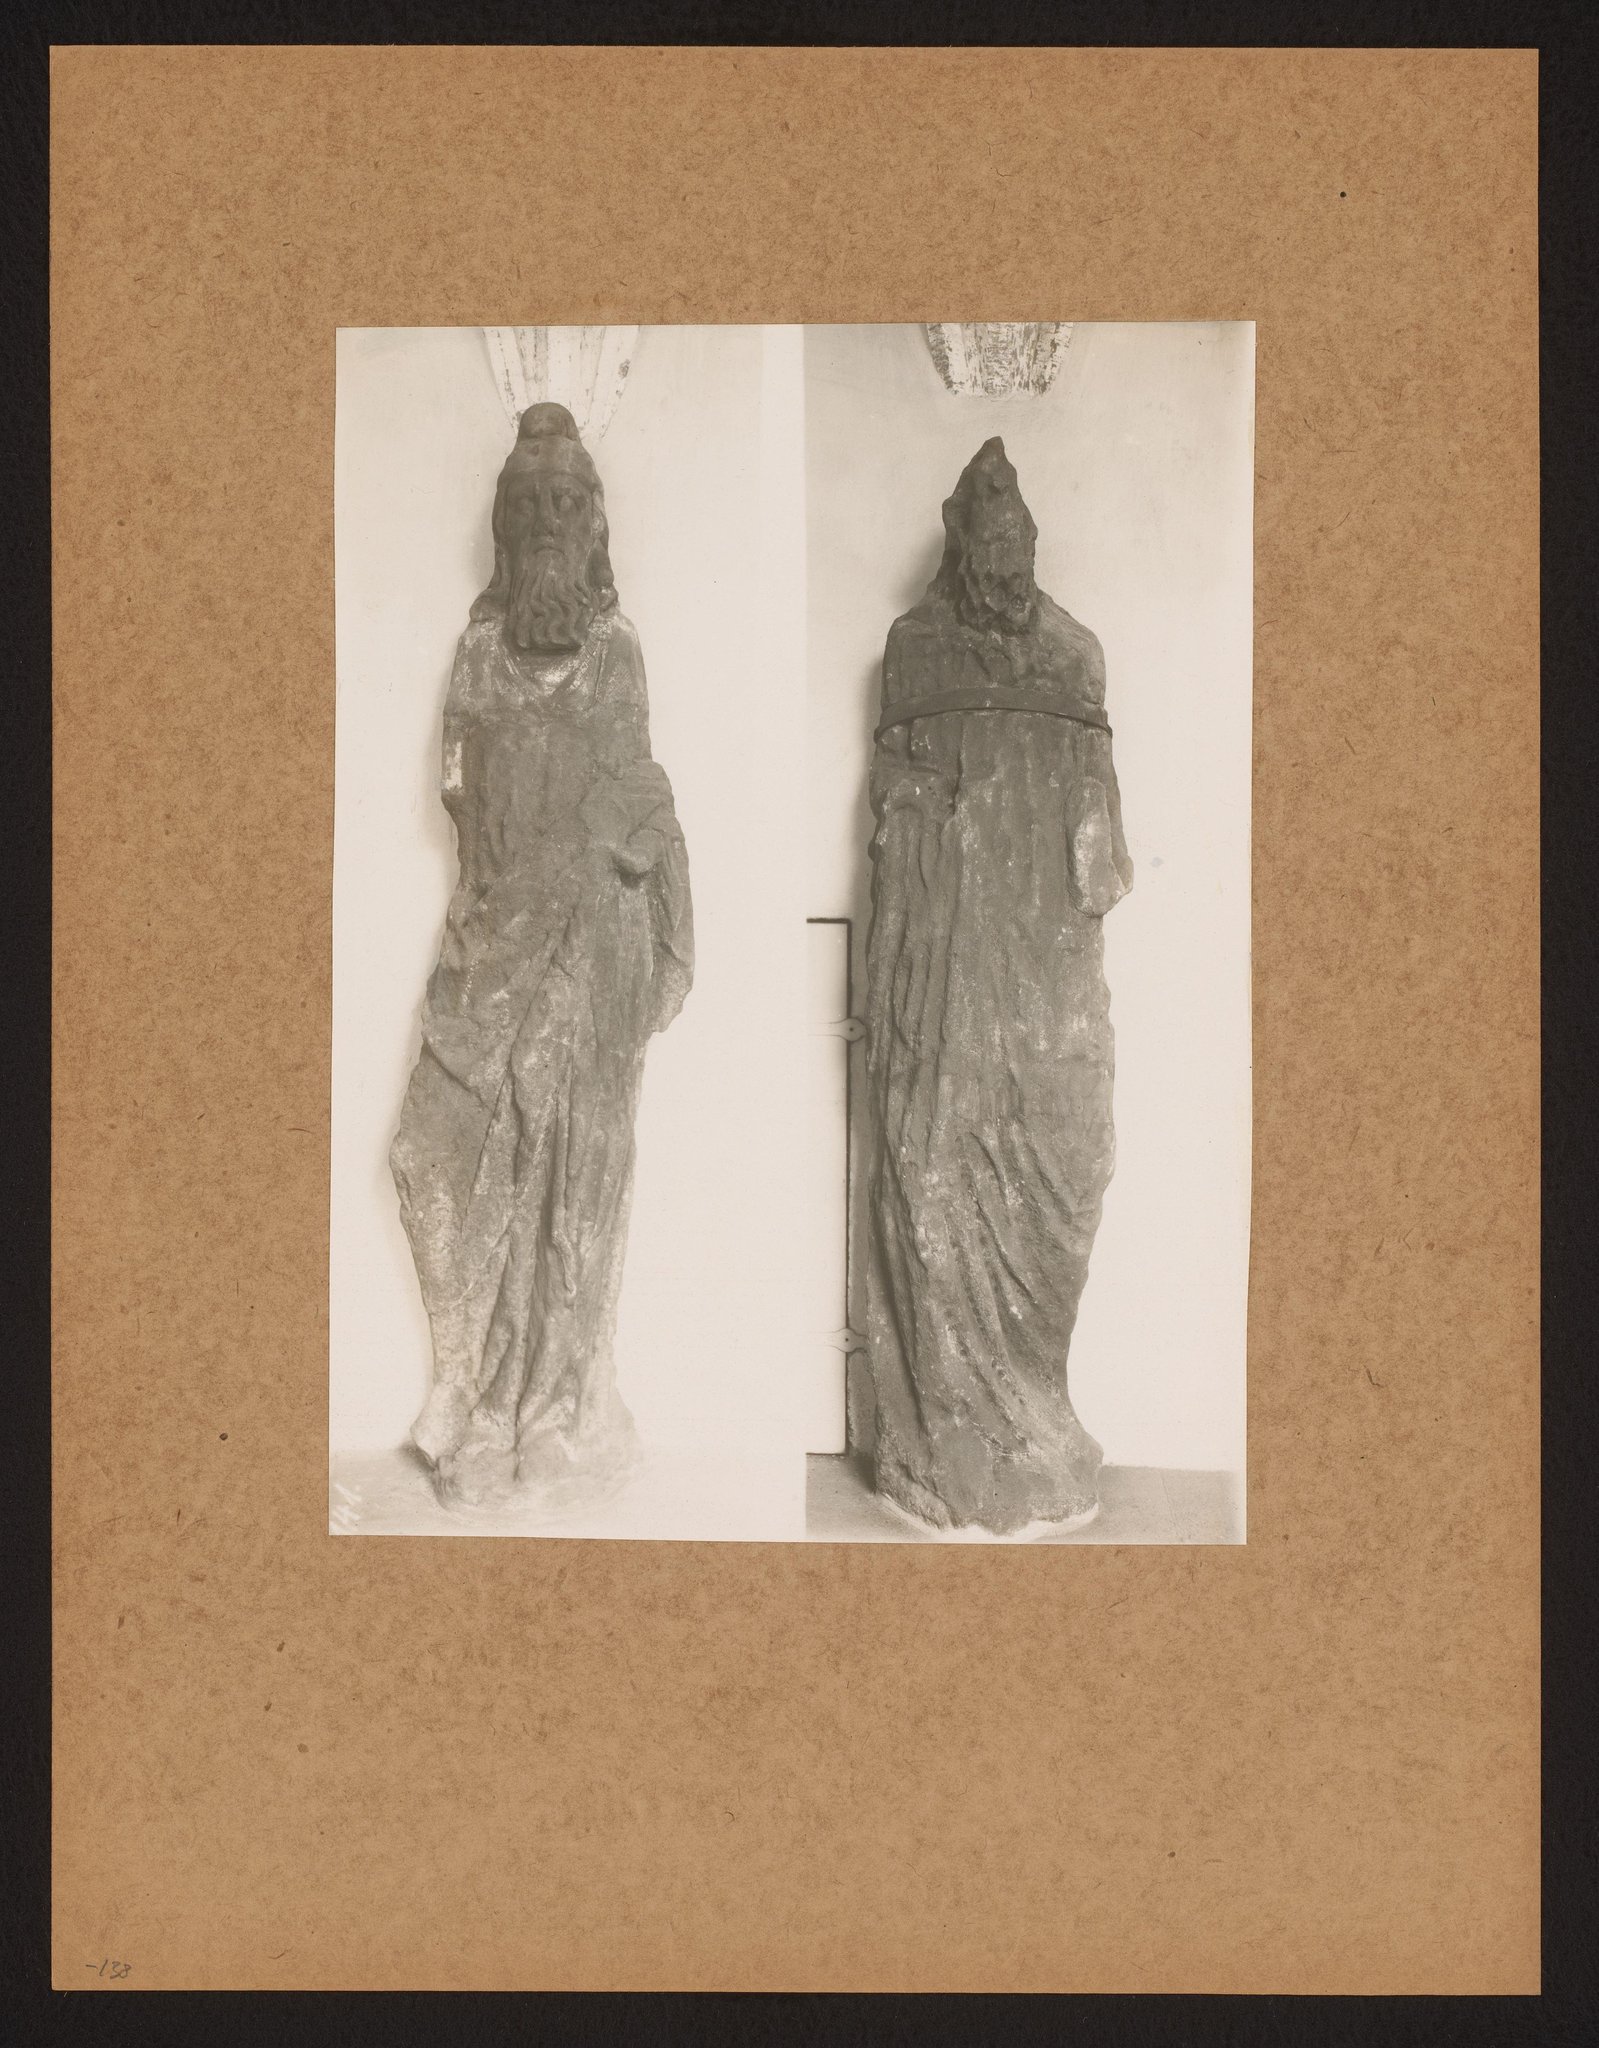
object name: photograph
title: Kreuzgang a) Prophet v. Turm b) P.v.T.m. barockem Kopf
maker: Anonymous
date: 1900-1920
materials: paper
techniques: gelatin silver print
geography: bamberg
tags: interior of church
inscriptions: number: ‘141’